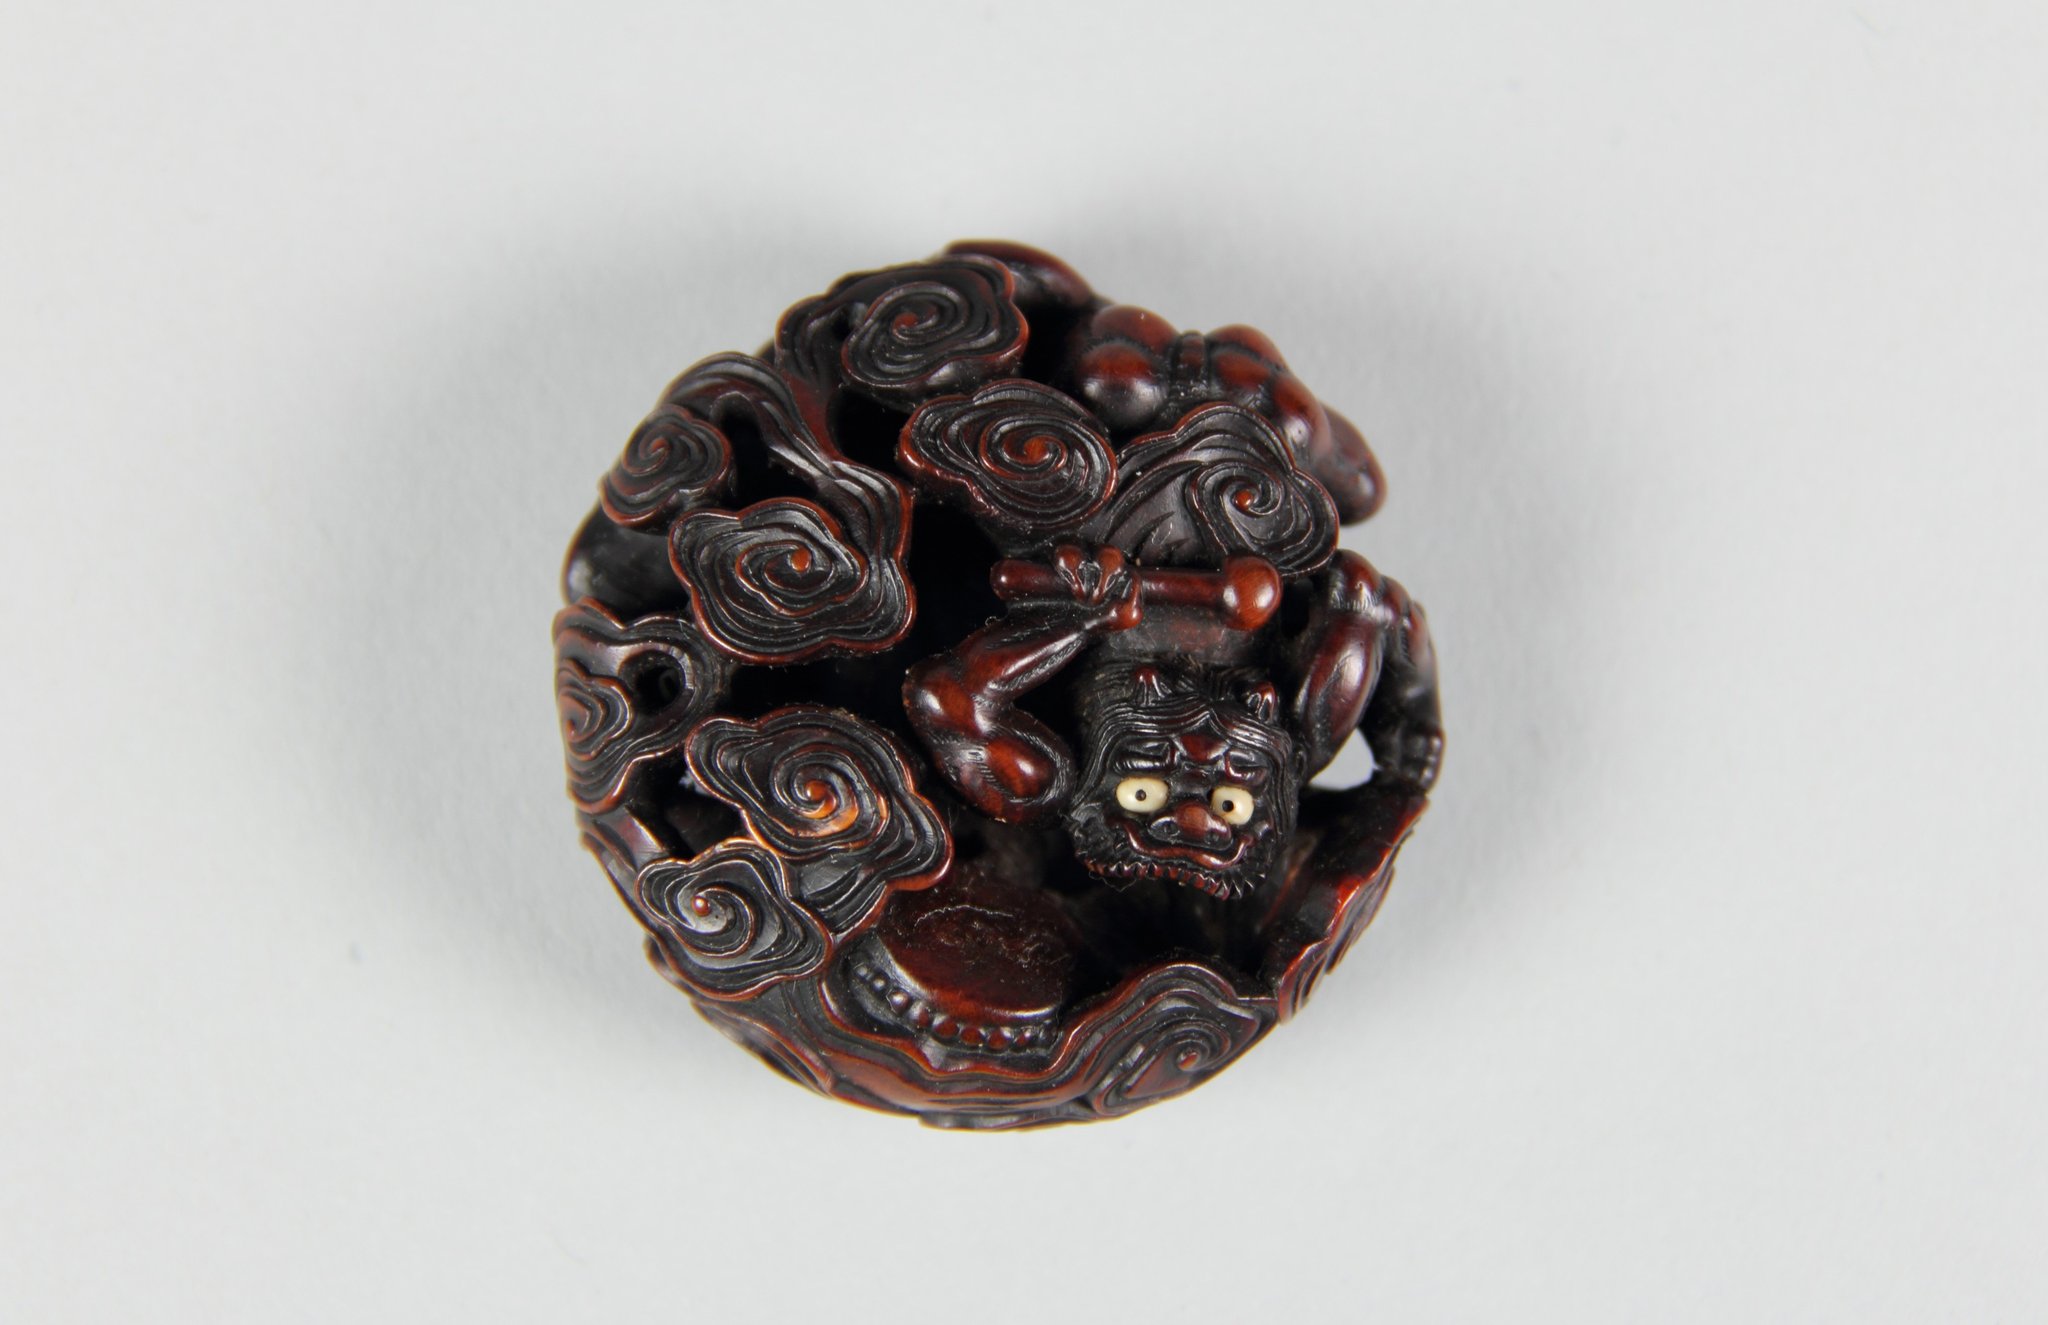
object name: netsuke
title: Netsuke of God of Thunder (Raijin) in Clouds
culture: japanese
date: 1701-1800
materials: wood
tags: gods